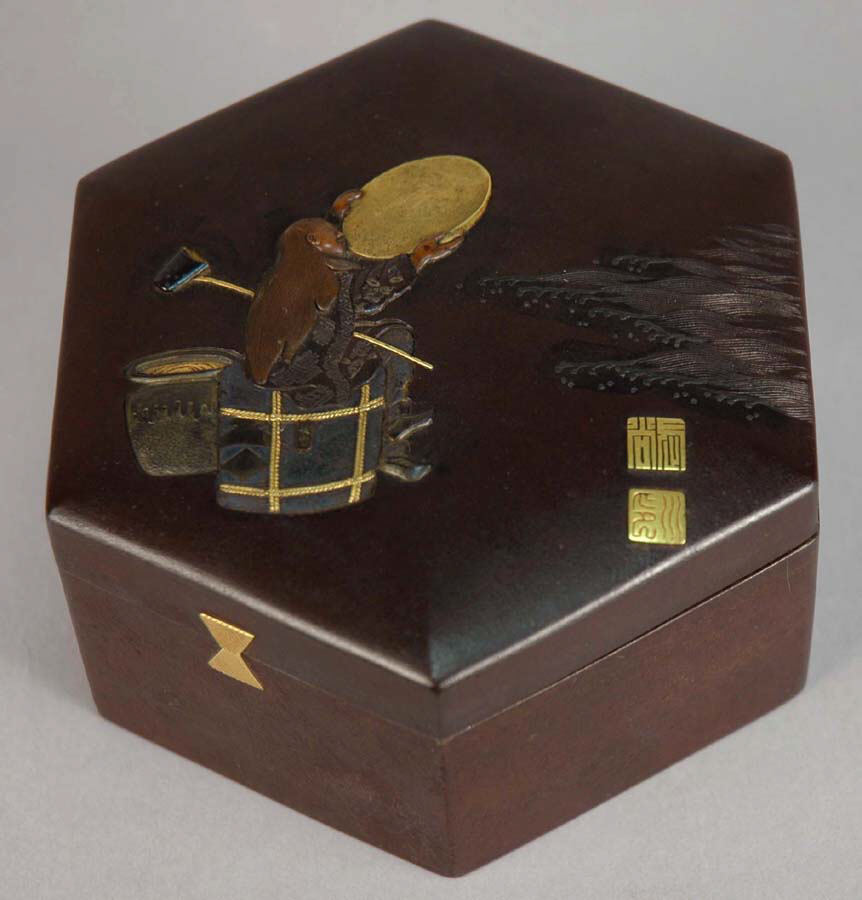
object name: box with cover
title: Box and Cover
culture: japanese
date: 1801-1900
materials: bronze, gold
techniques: inlay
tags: human figures